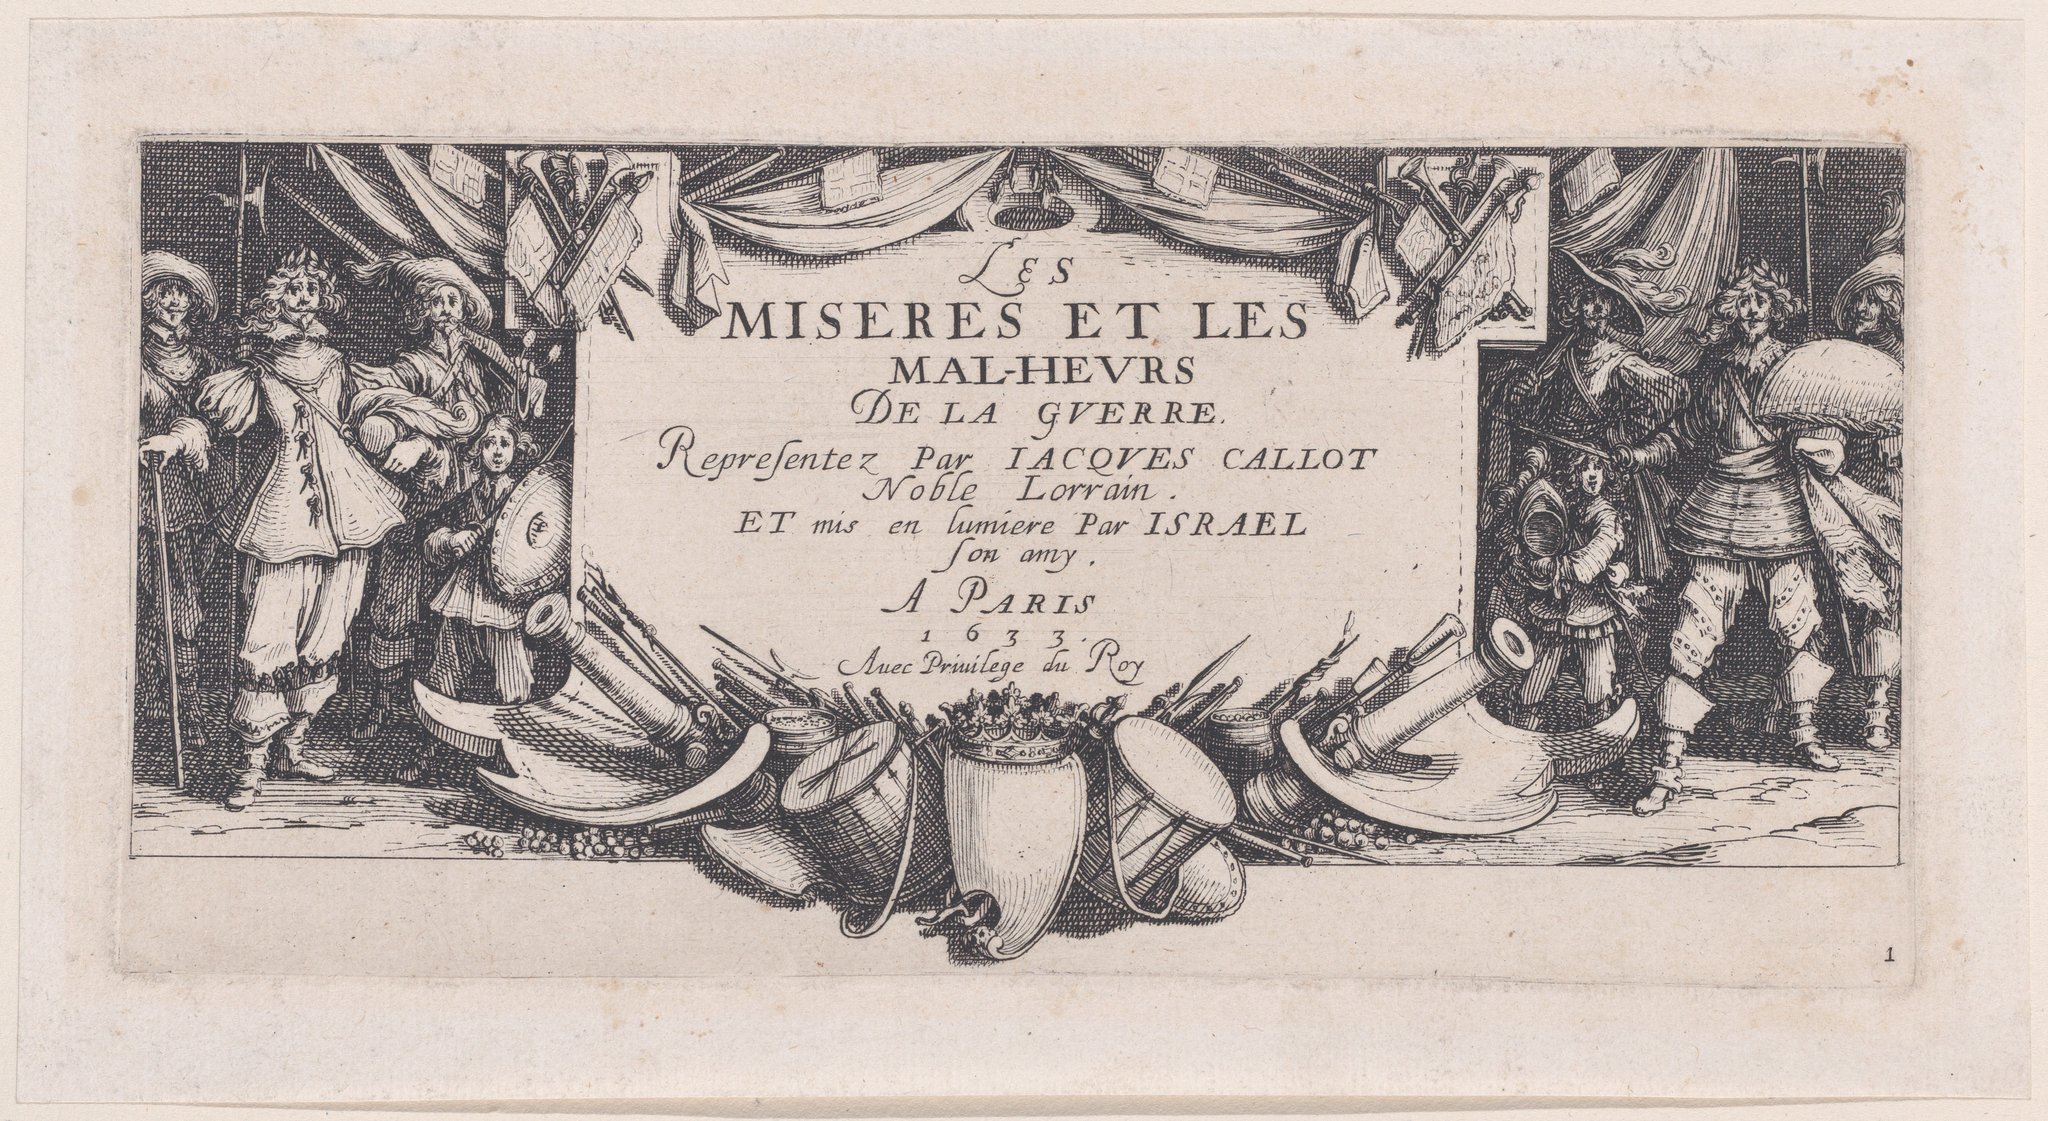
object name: print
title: Frontispiece, plate 1 from "Les Misères et les Mal-Heures de la Guerre" (The Miseries and Misfortunes of War)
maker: jacques callot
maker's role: artist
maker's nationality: french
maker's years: 1592-1635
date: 1633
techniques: etching